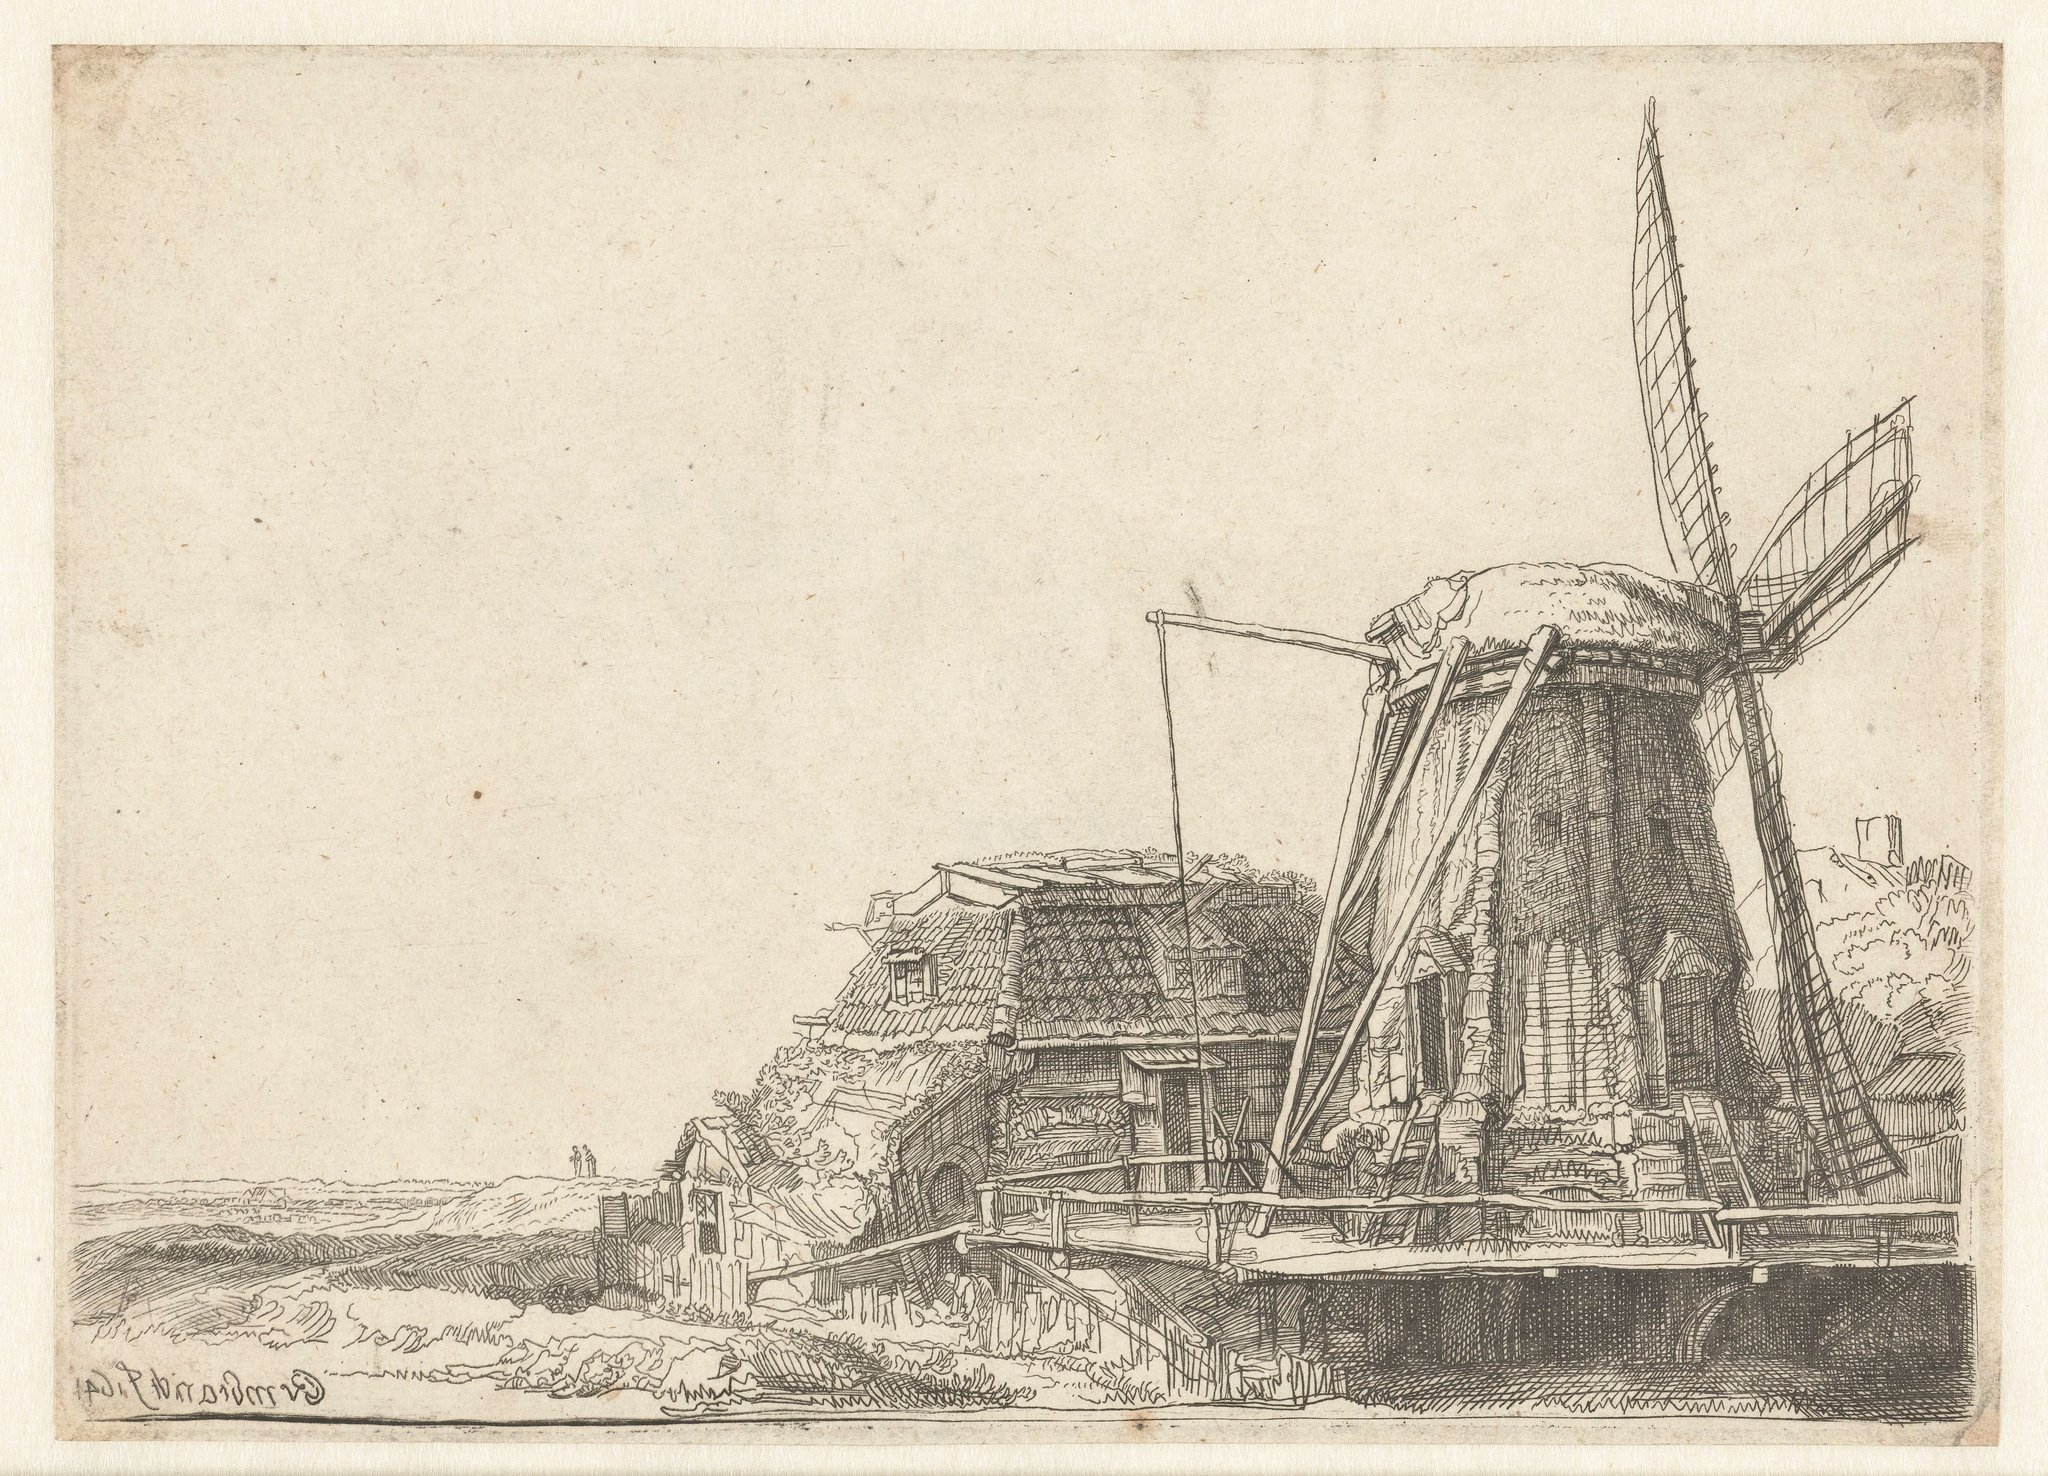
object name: print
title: The windmill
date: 1727-1764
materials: paper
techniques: etching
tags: windmill in landscape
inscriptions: collector's mark: Lugt 2228, collector's mark: Lugt 2760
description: Spiegelbeeldige kopie naar de gelijknamige prent van Rembrandt.